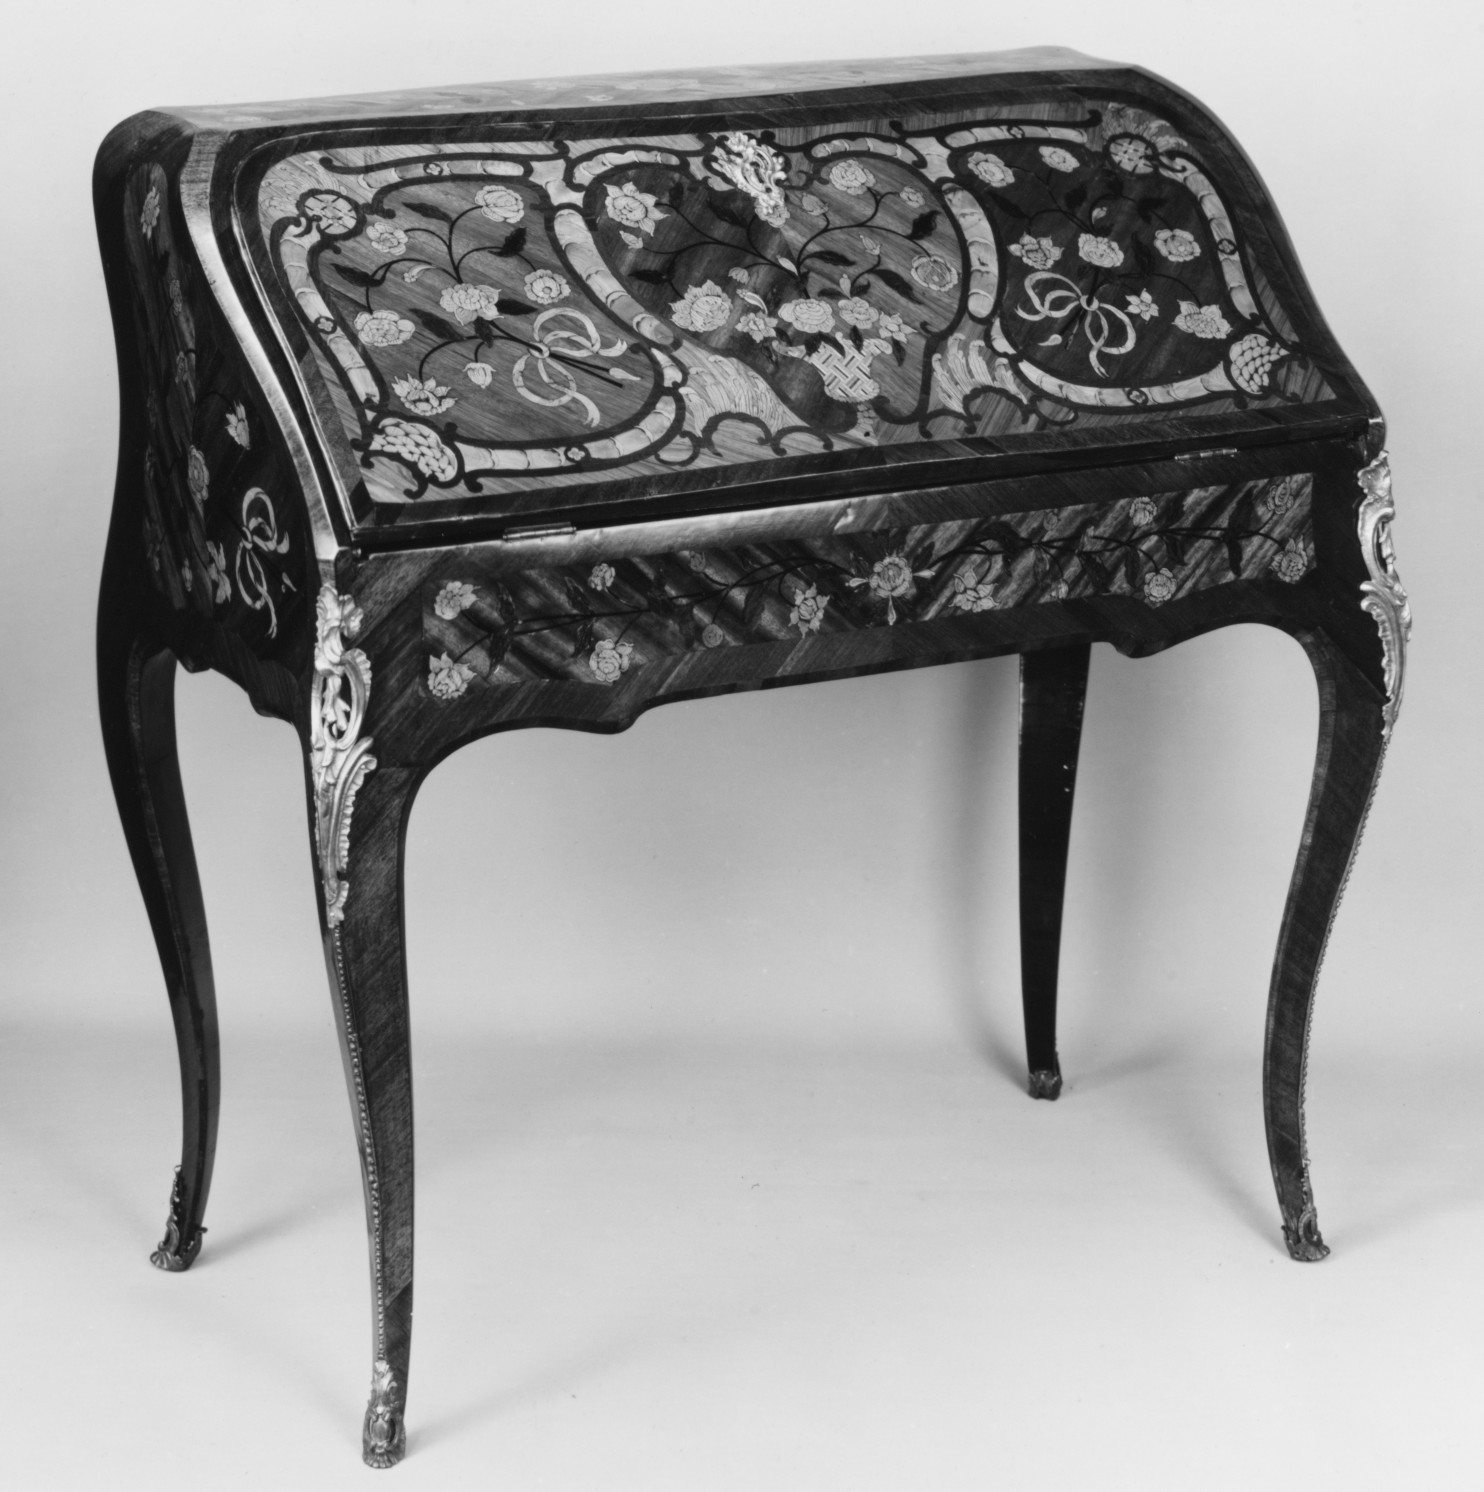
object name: slant top desk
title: Slant-top desk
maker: jean-baptiste i. tuart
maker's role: maker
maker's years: 1700-1767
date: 1734-1766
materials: leather, wood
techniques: stain